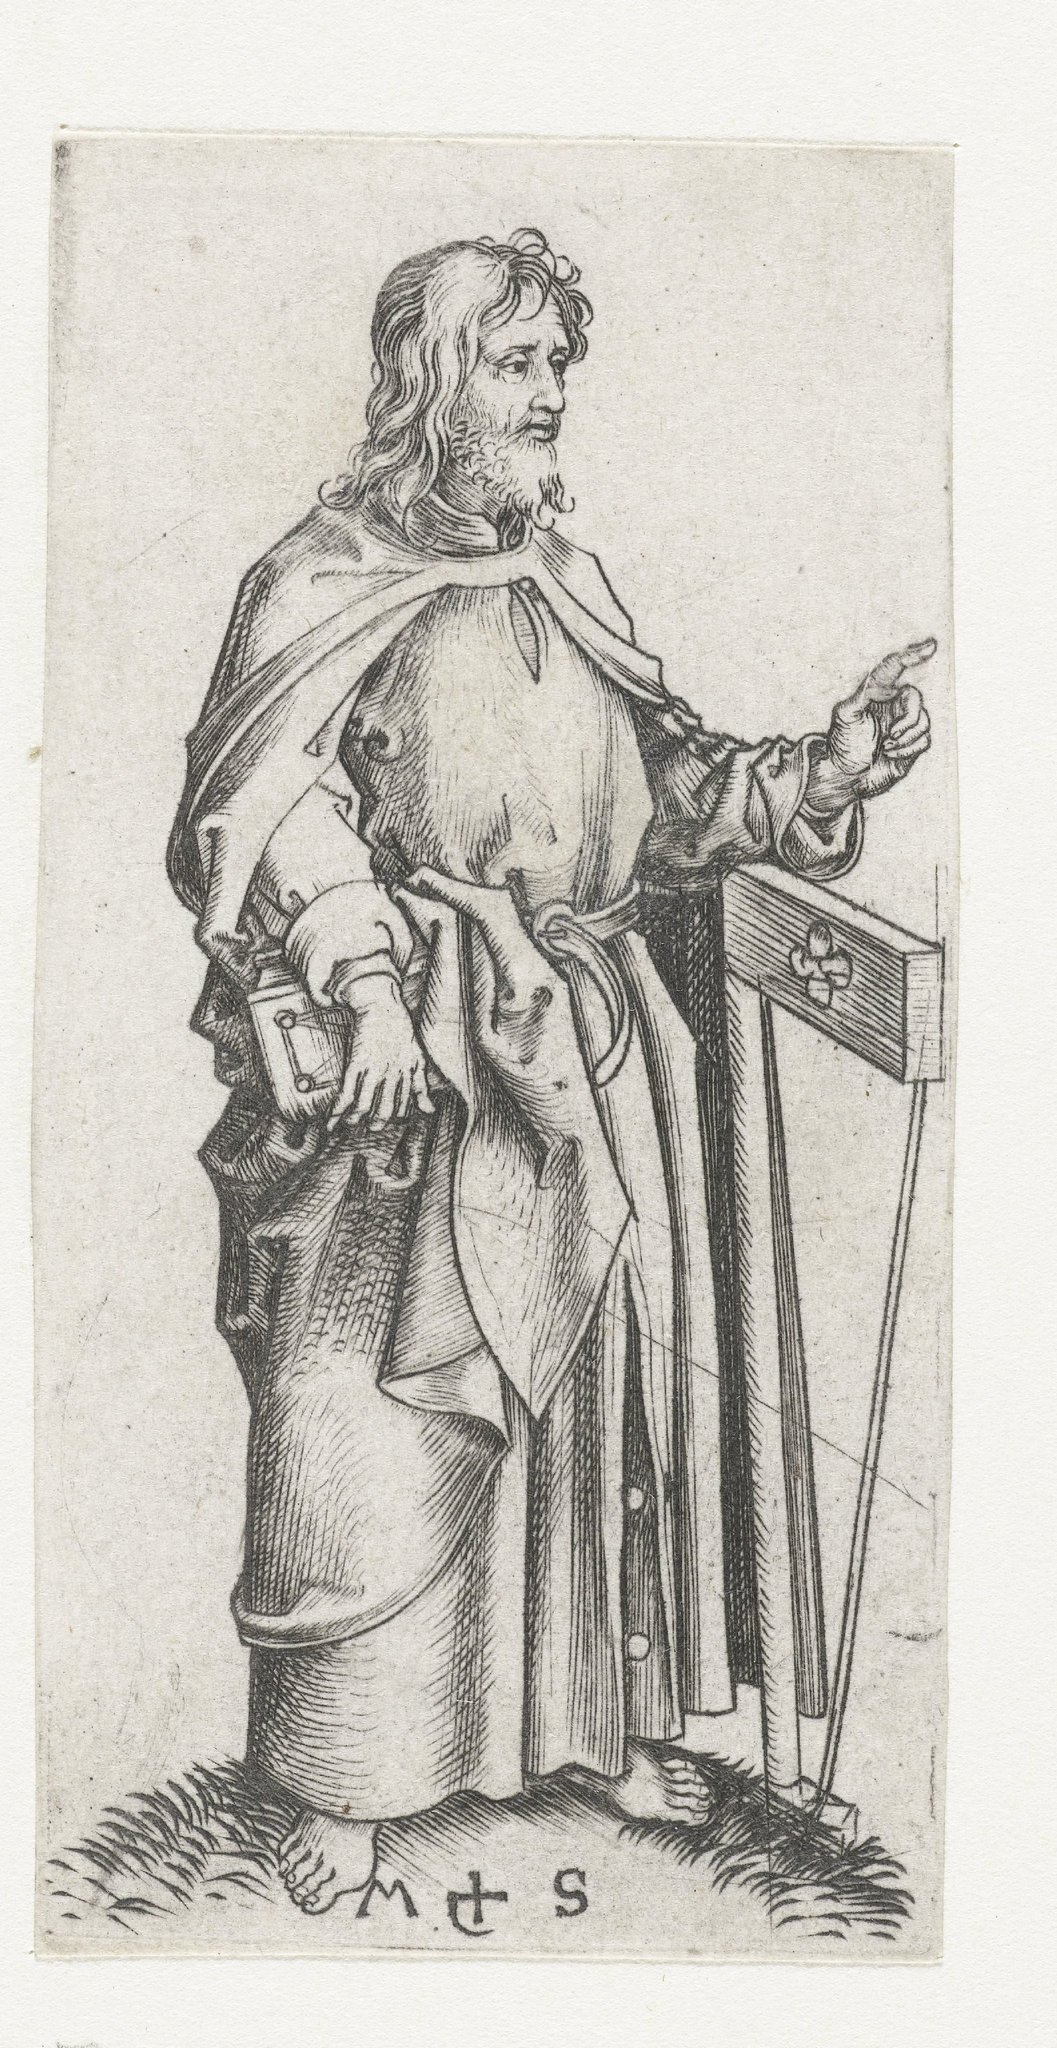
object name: print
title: De twaalf apostelen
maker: martin schongauer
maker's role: print maker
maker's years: 1430-1491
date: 1470-1491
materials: paper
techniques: engraving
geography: germany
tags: the apostle jude thaddaeus; possible attributes: book, club, halberd, scroll, the apostle james the less, first bishop of jerusalem; possible attributes: book, fuller's club, scroll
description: De apostel Jakobus de Mindere (Judas Thaddeüs?), ten voeten uit, met een boek in de hand, steunend op een hoedenmakersboog (?). Deze prent is onderdeel van een serie van twaalf portretten van de apostelen.